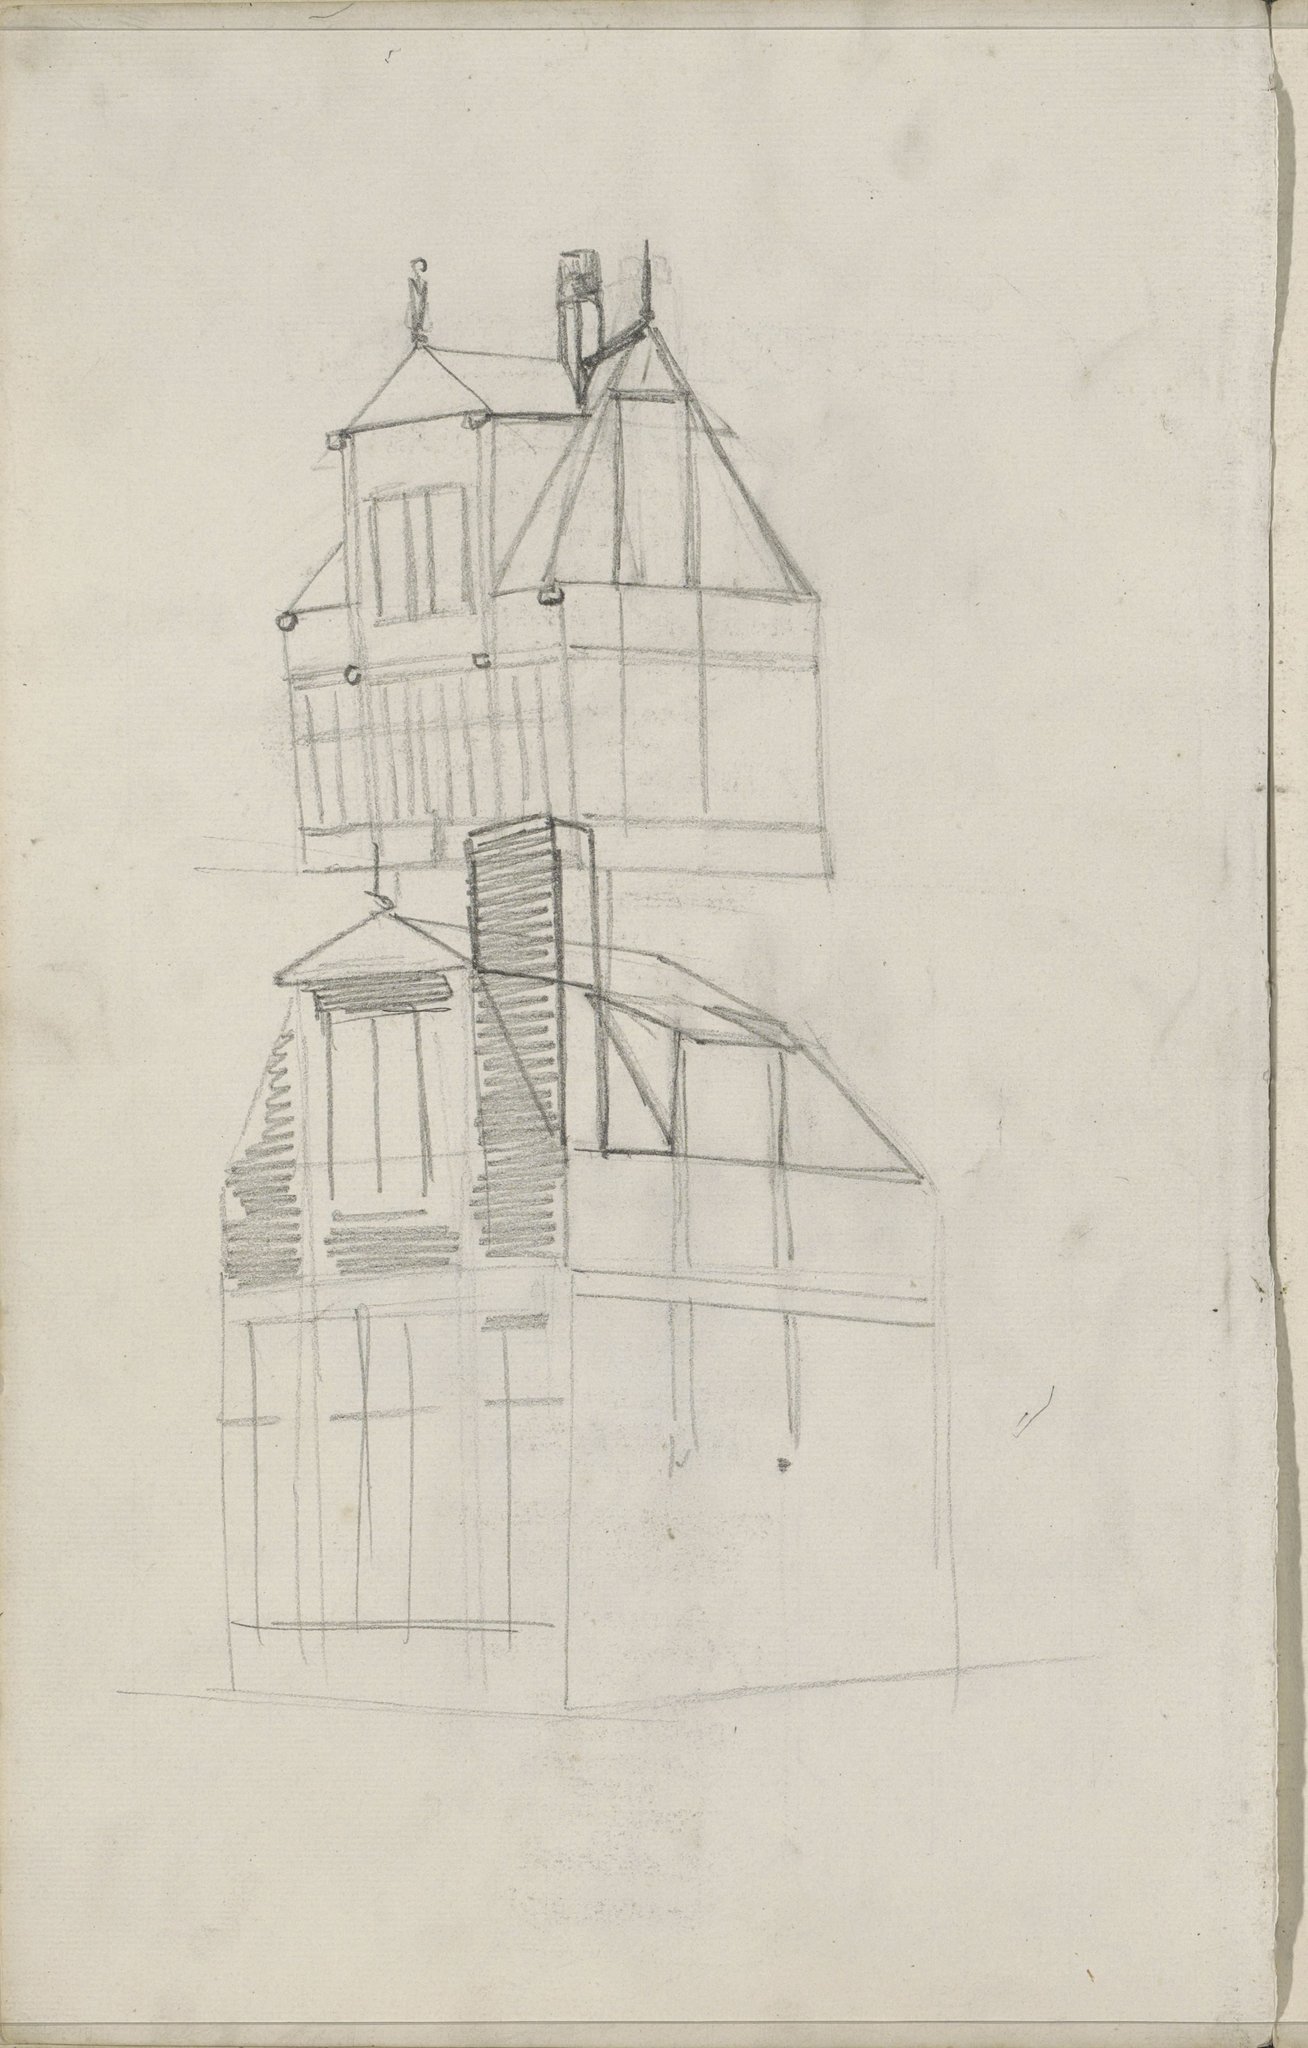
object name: sketchbook leaf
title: Huis met een puntdak en een schoorsteen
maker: carel adolph lion cachet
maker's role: draughtsman, print maker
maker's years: 1864-1945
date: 1895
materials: paper, pencil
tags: interior of the house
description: Blad 18 verso uit een schetsboek met 23 bladen.